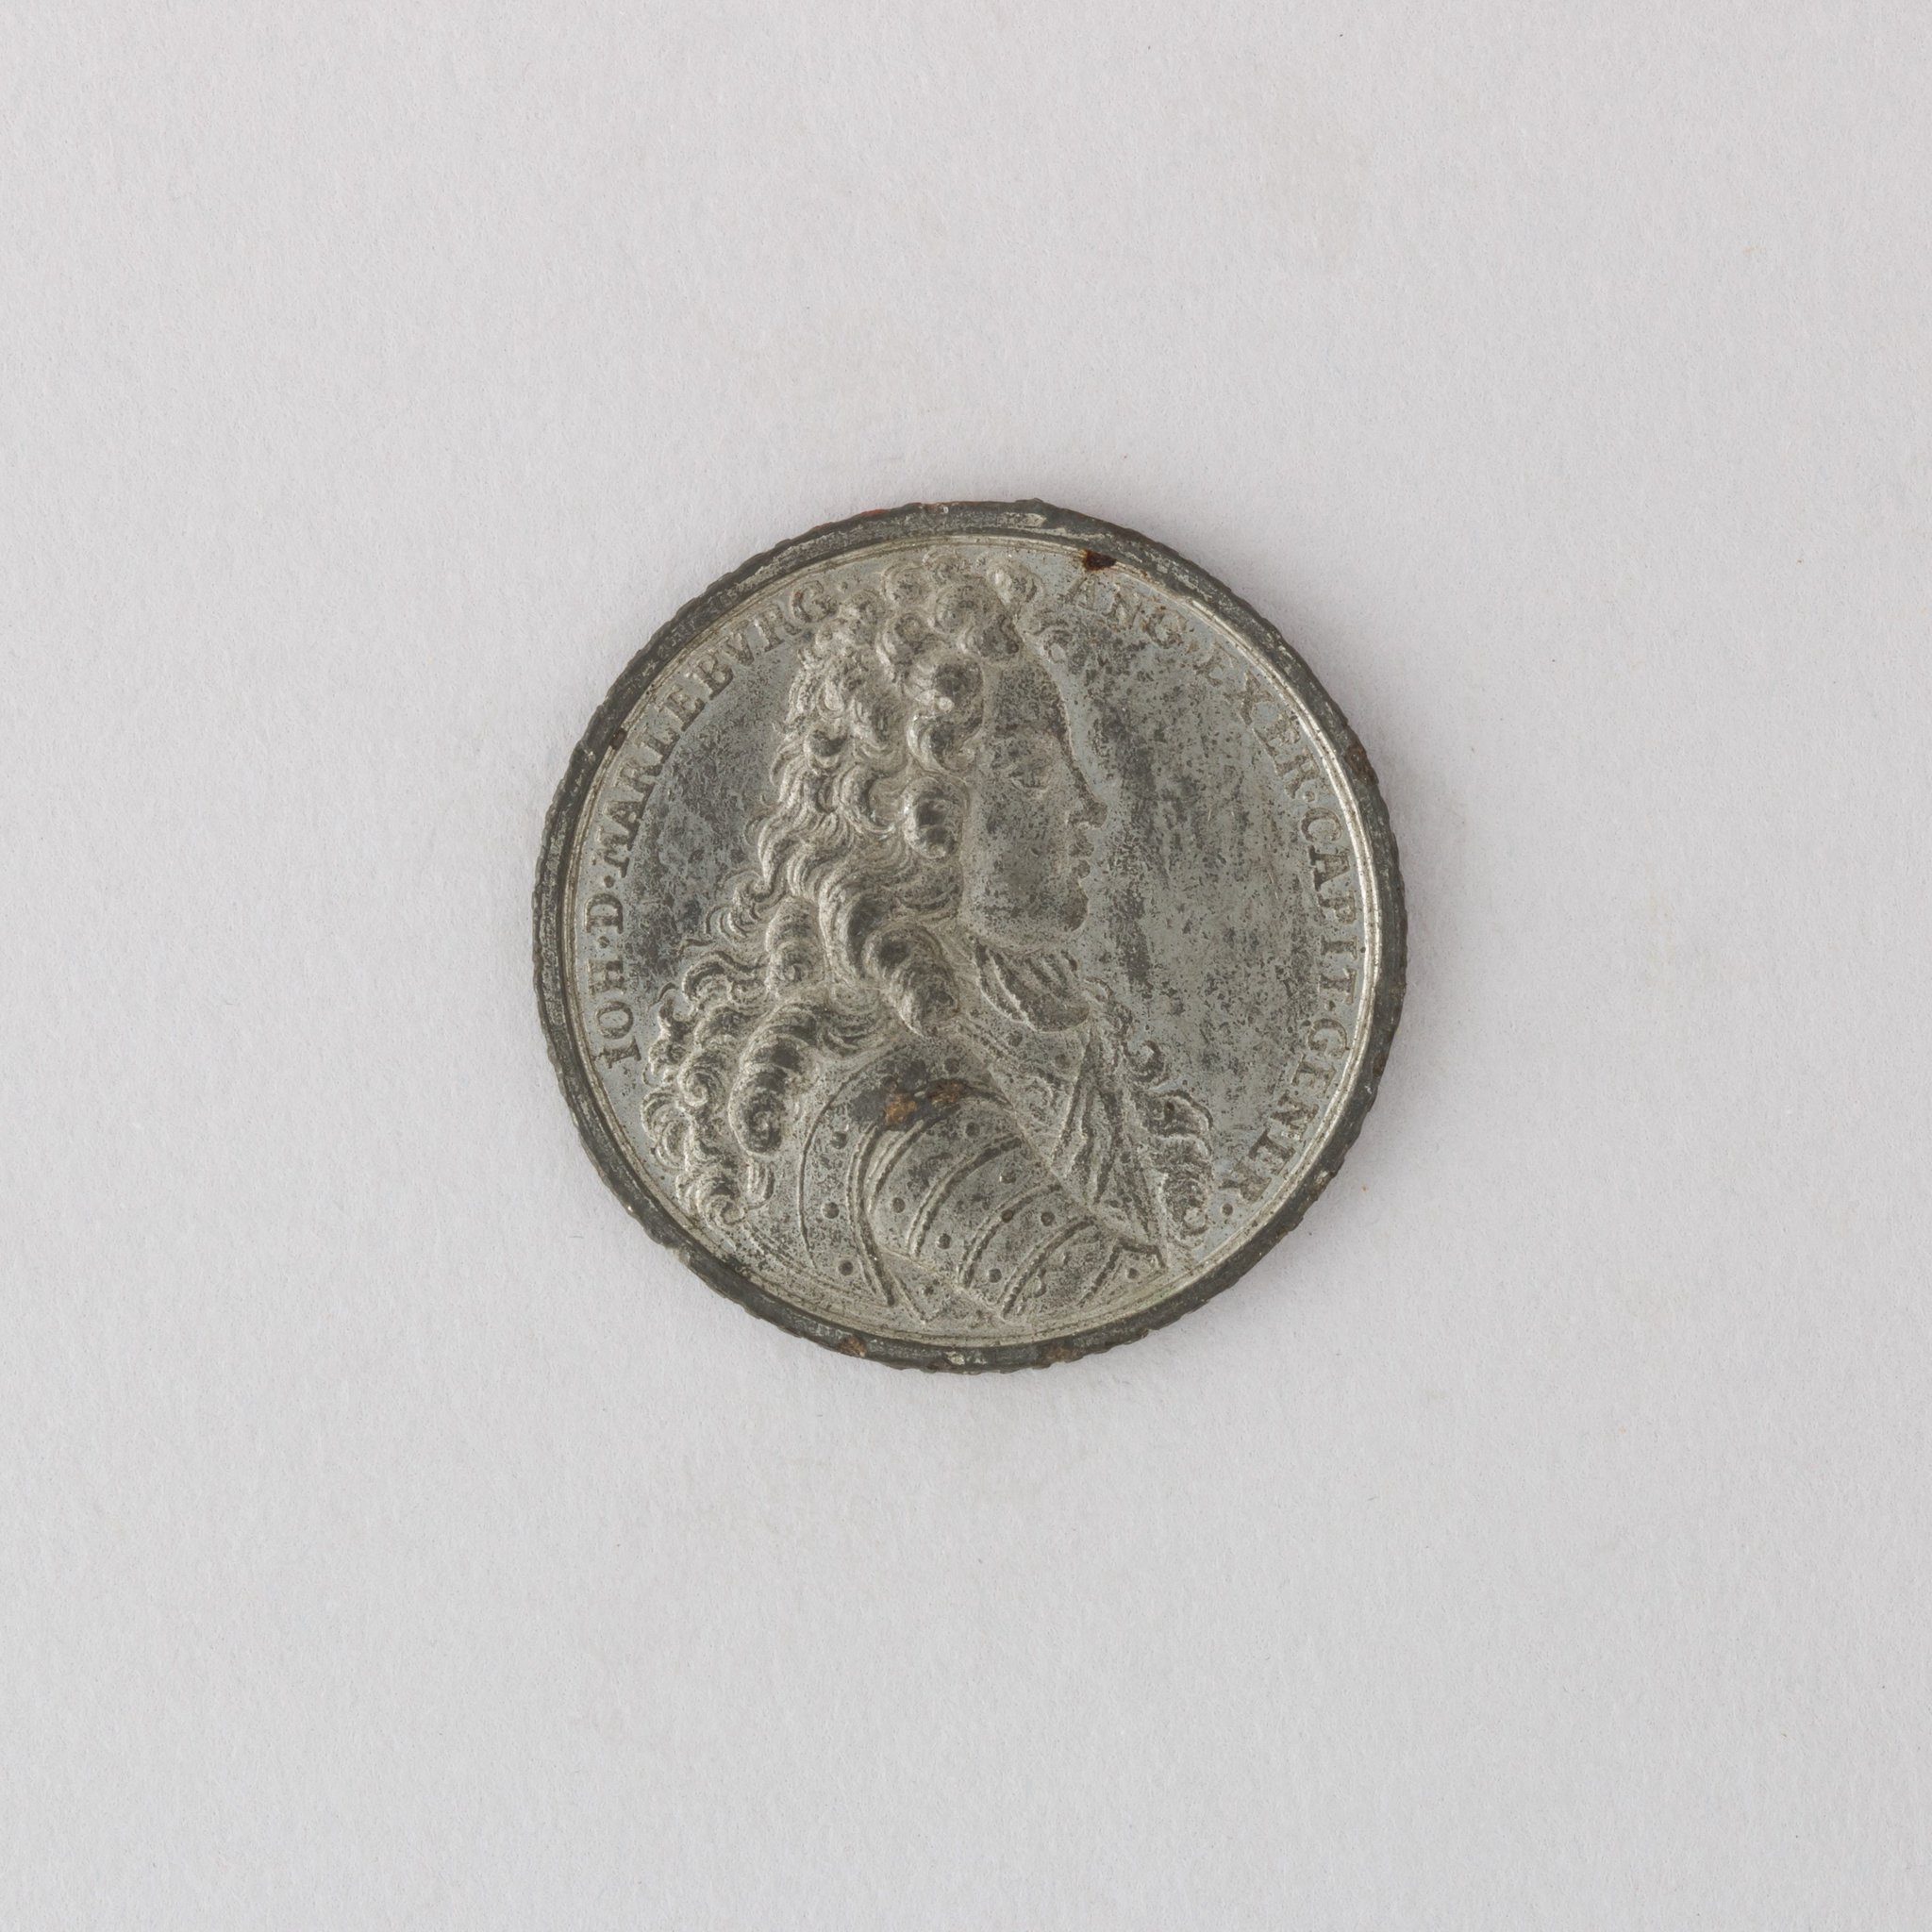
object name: medal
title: Medal Commemorating the Battle of Blenheim, showing the Duke of Marlborough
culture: british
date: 1704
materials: pewter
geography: england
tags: men,profiles